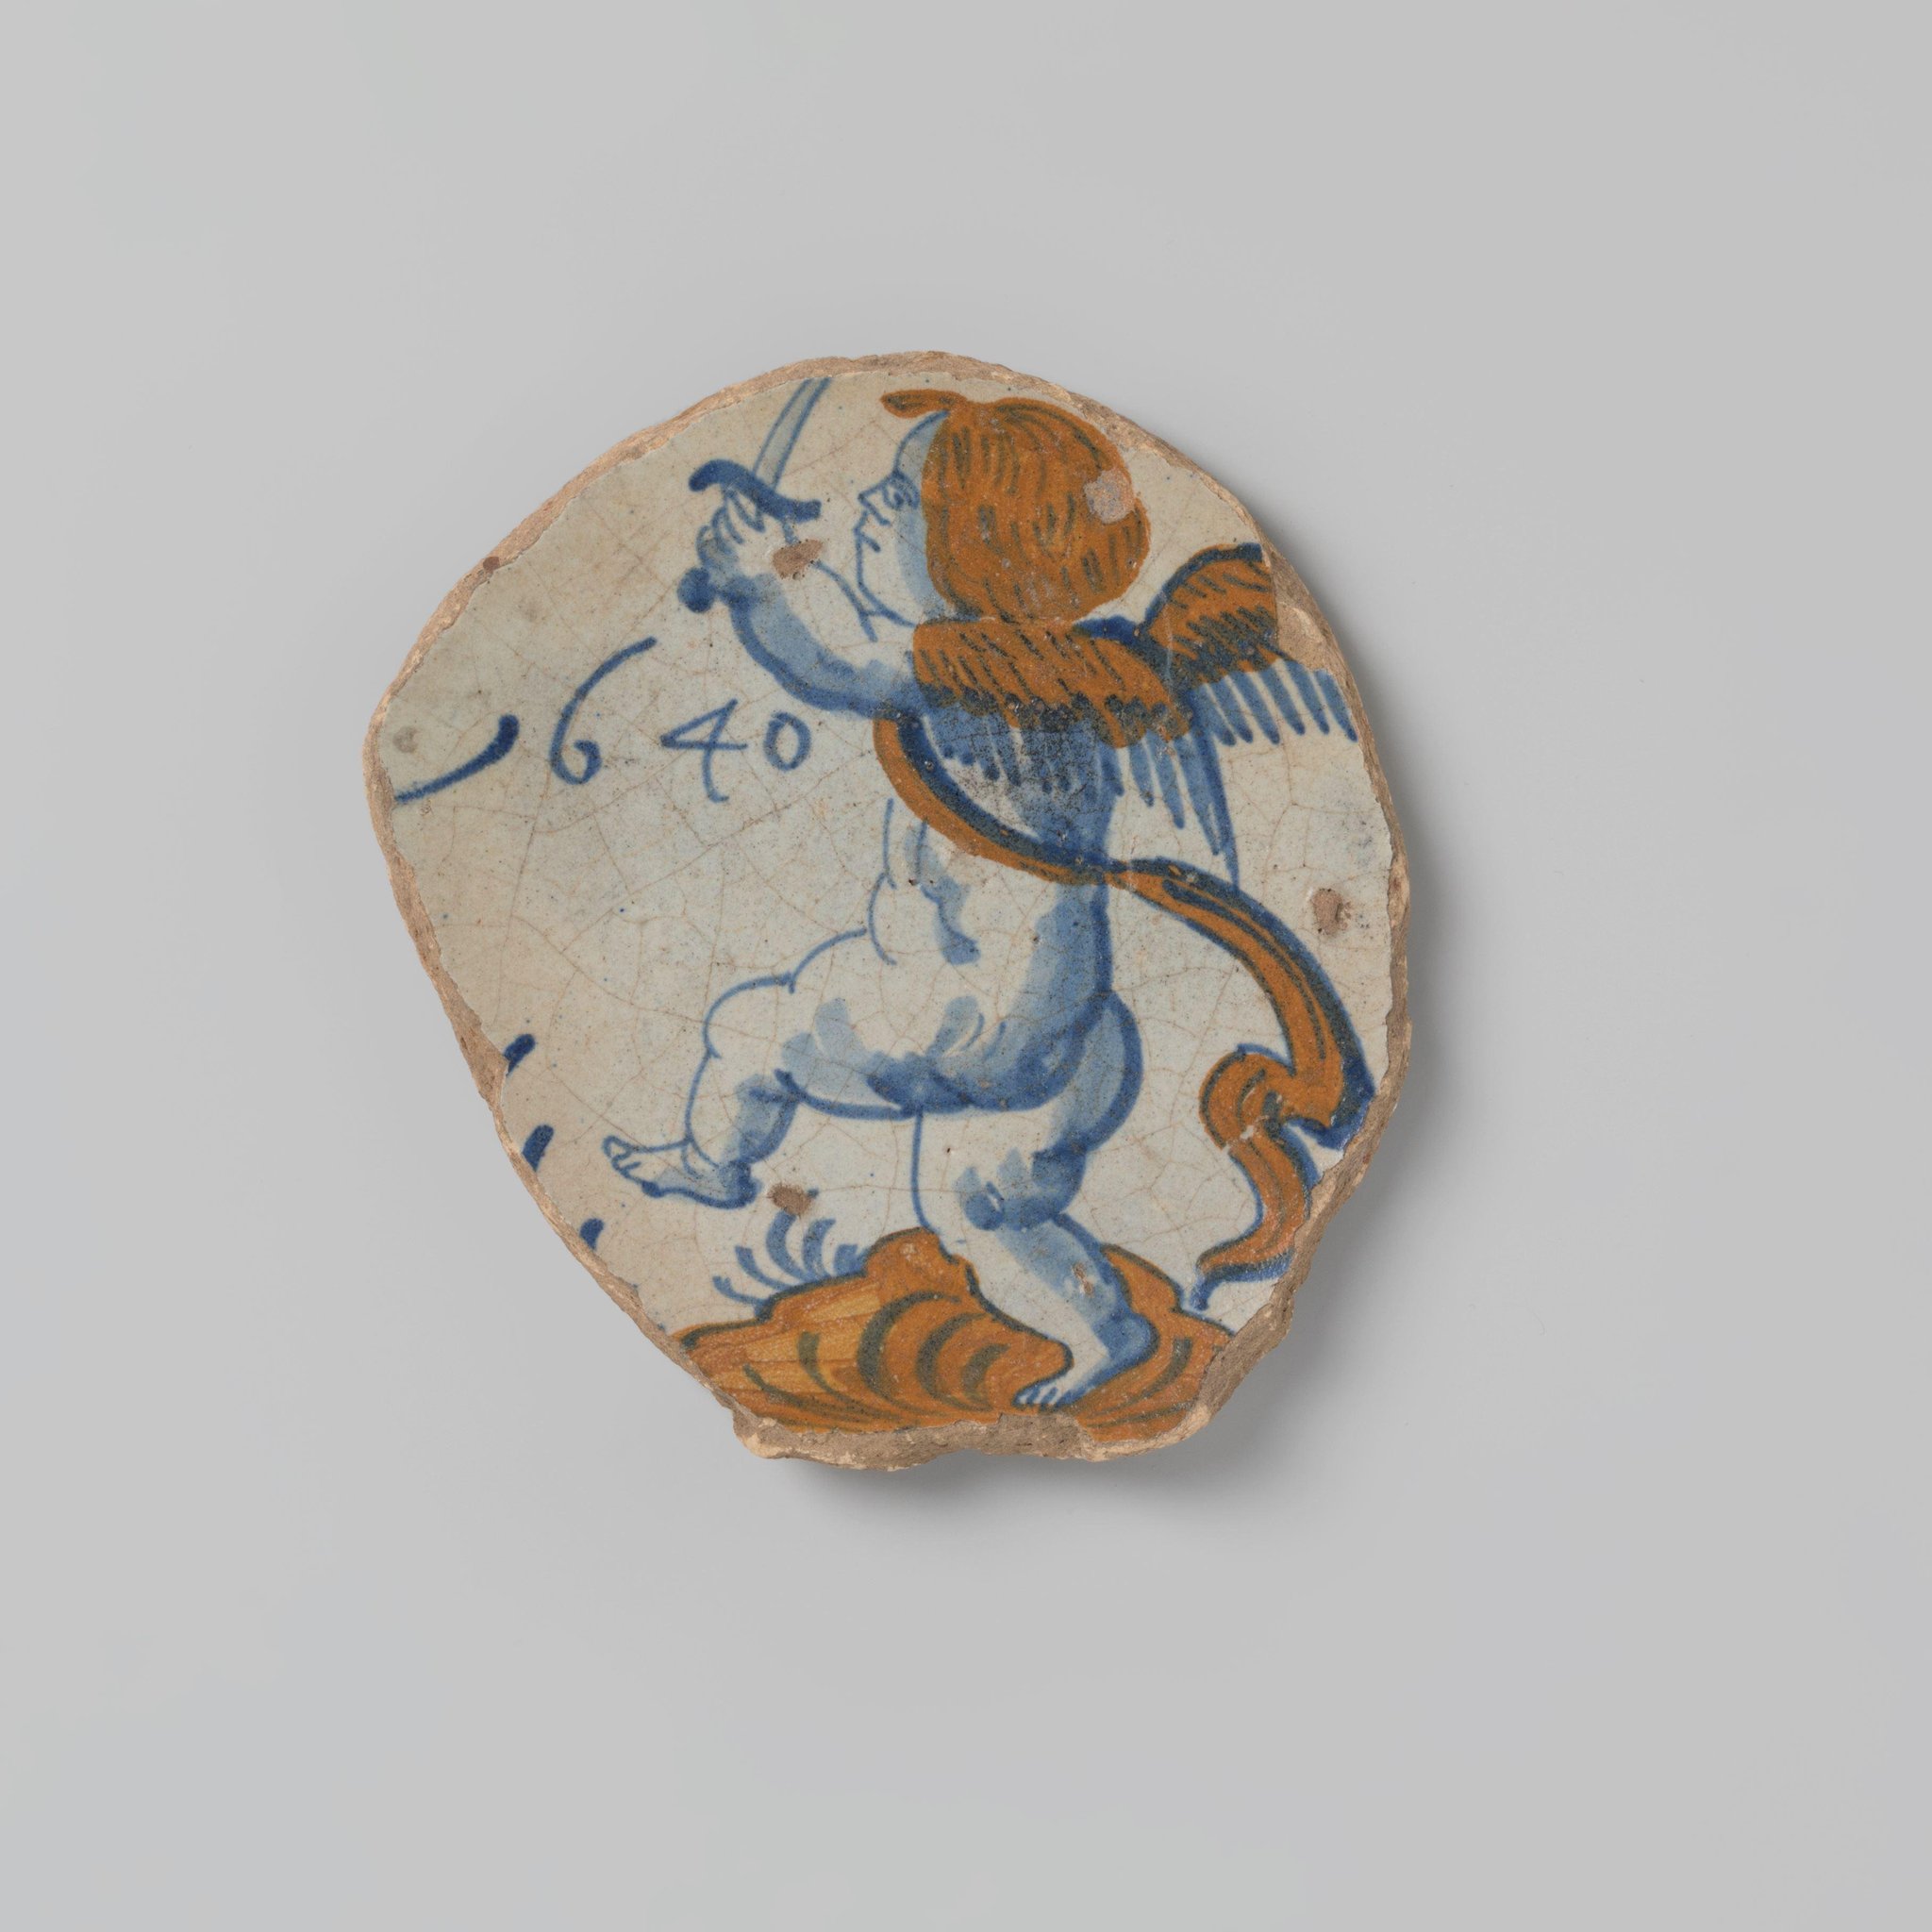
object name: sherd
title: Schotelscherf van aardewerk met veelkleurige tekening van een putto met zwaard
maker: Anonymous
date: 1640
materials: earthenware, glaze